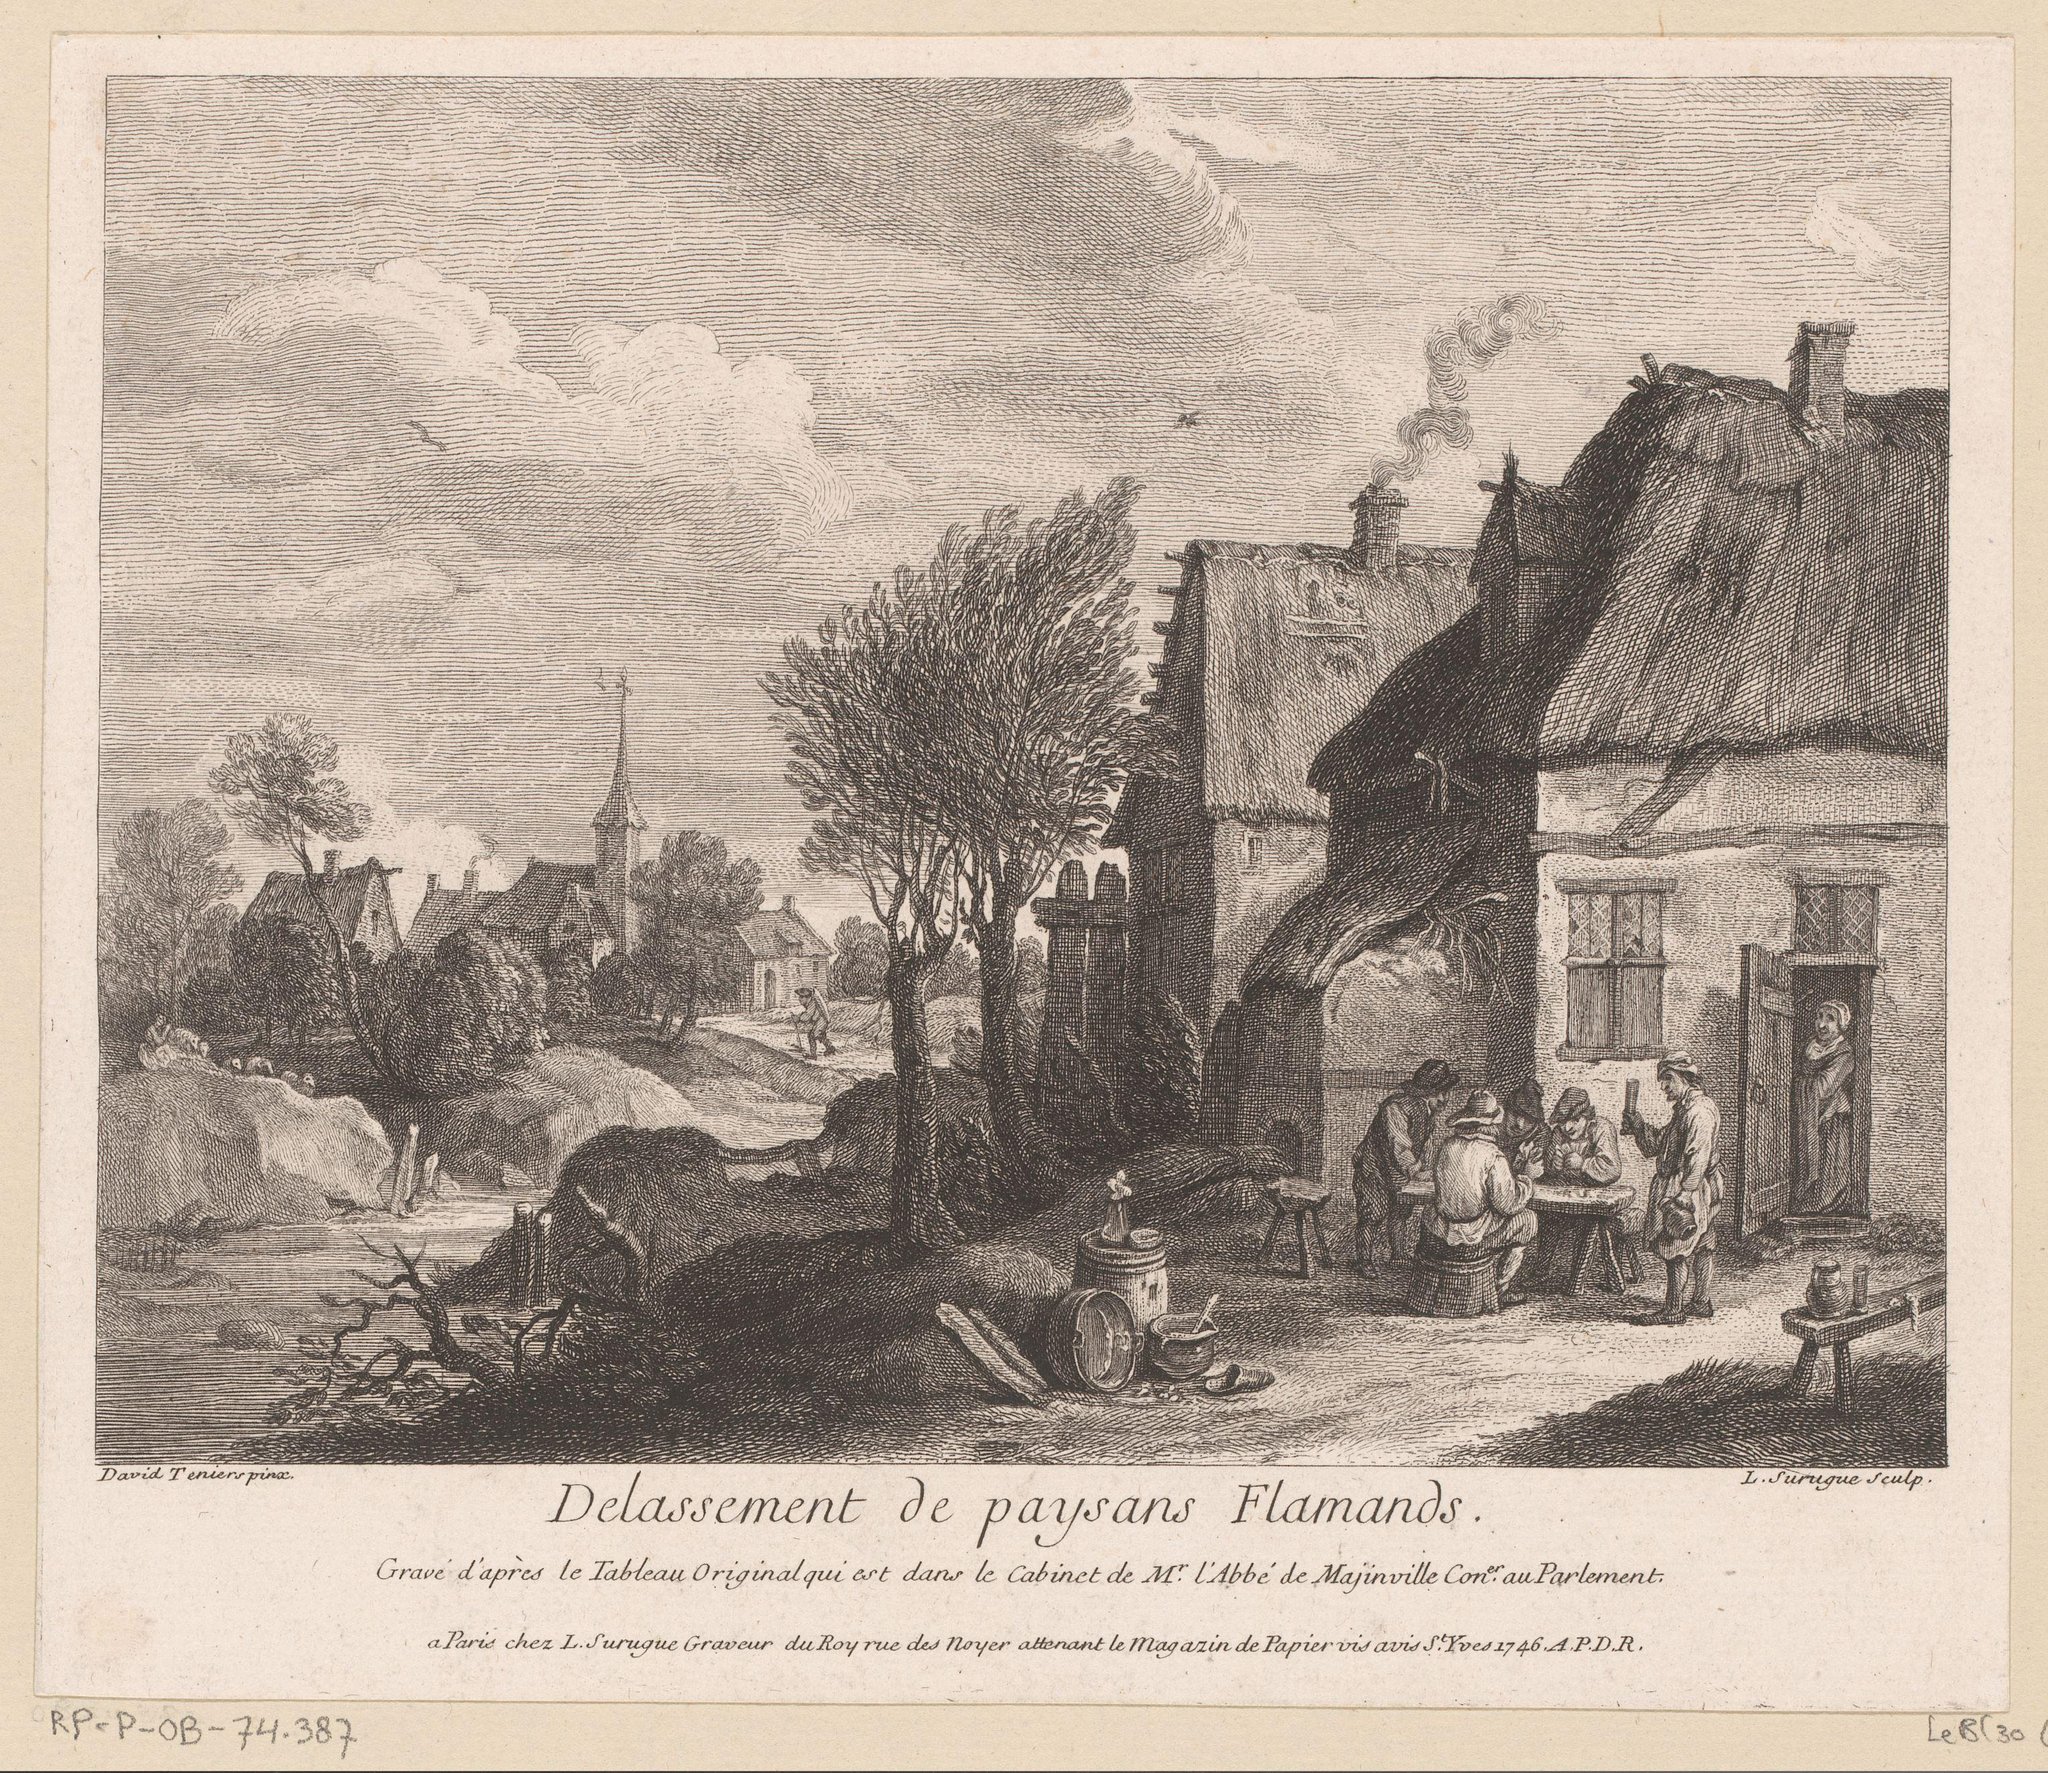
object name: print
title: Delassement de paysans Flamands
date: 1746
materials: paper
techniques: engraving, etching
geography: france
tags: village, playing-cards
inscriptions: collector's mark: Lugt 240